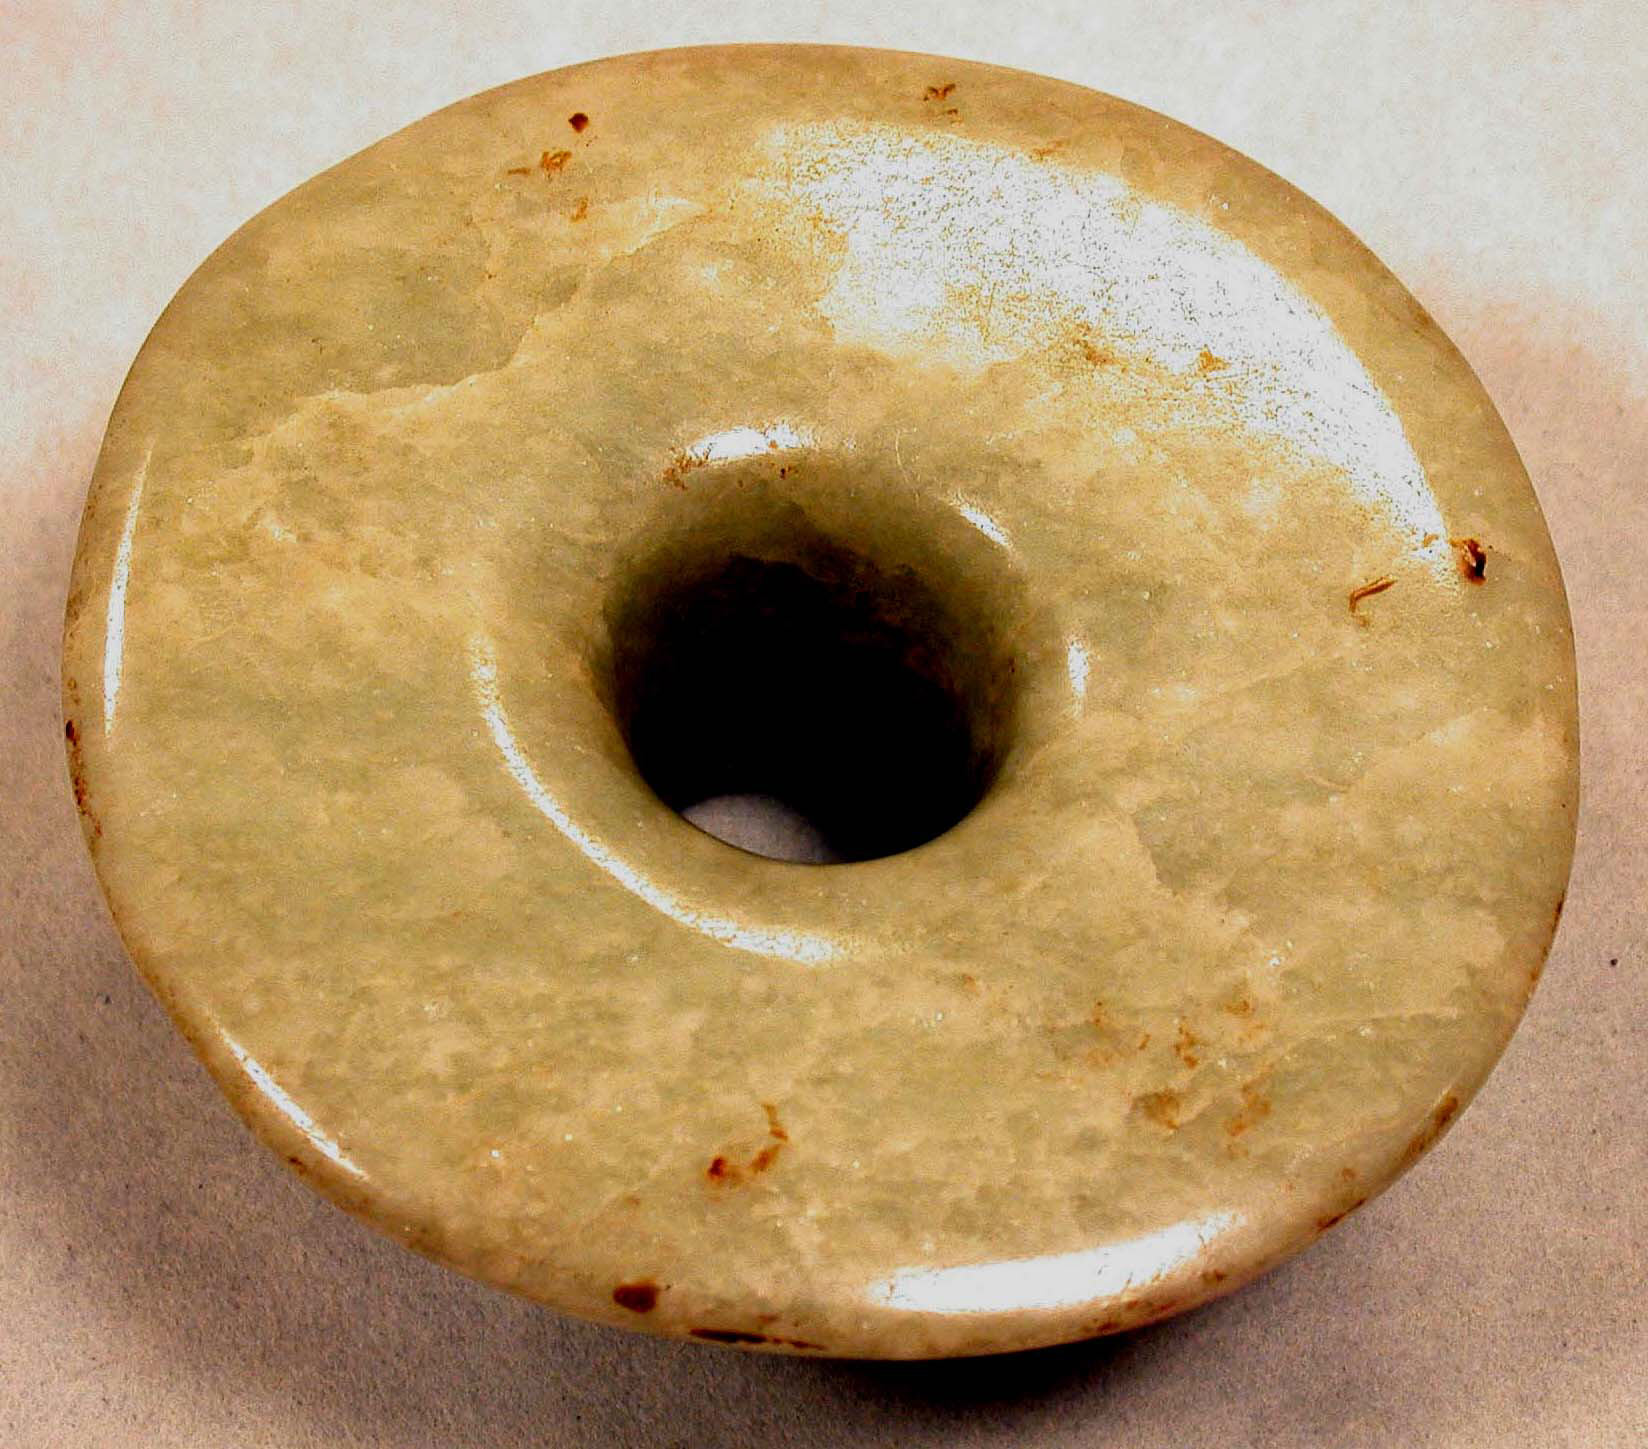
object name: earflare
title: Stone Earflare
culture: mexican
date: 1501-1600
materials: stone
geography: mexico